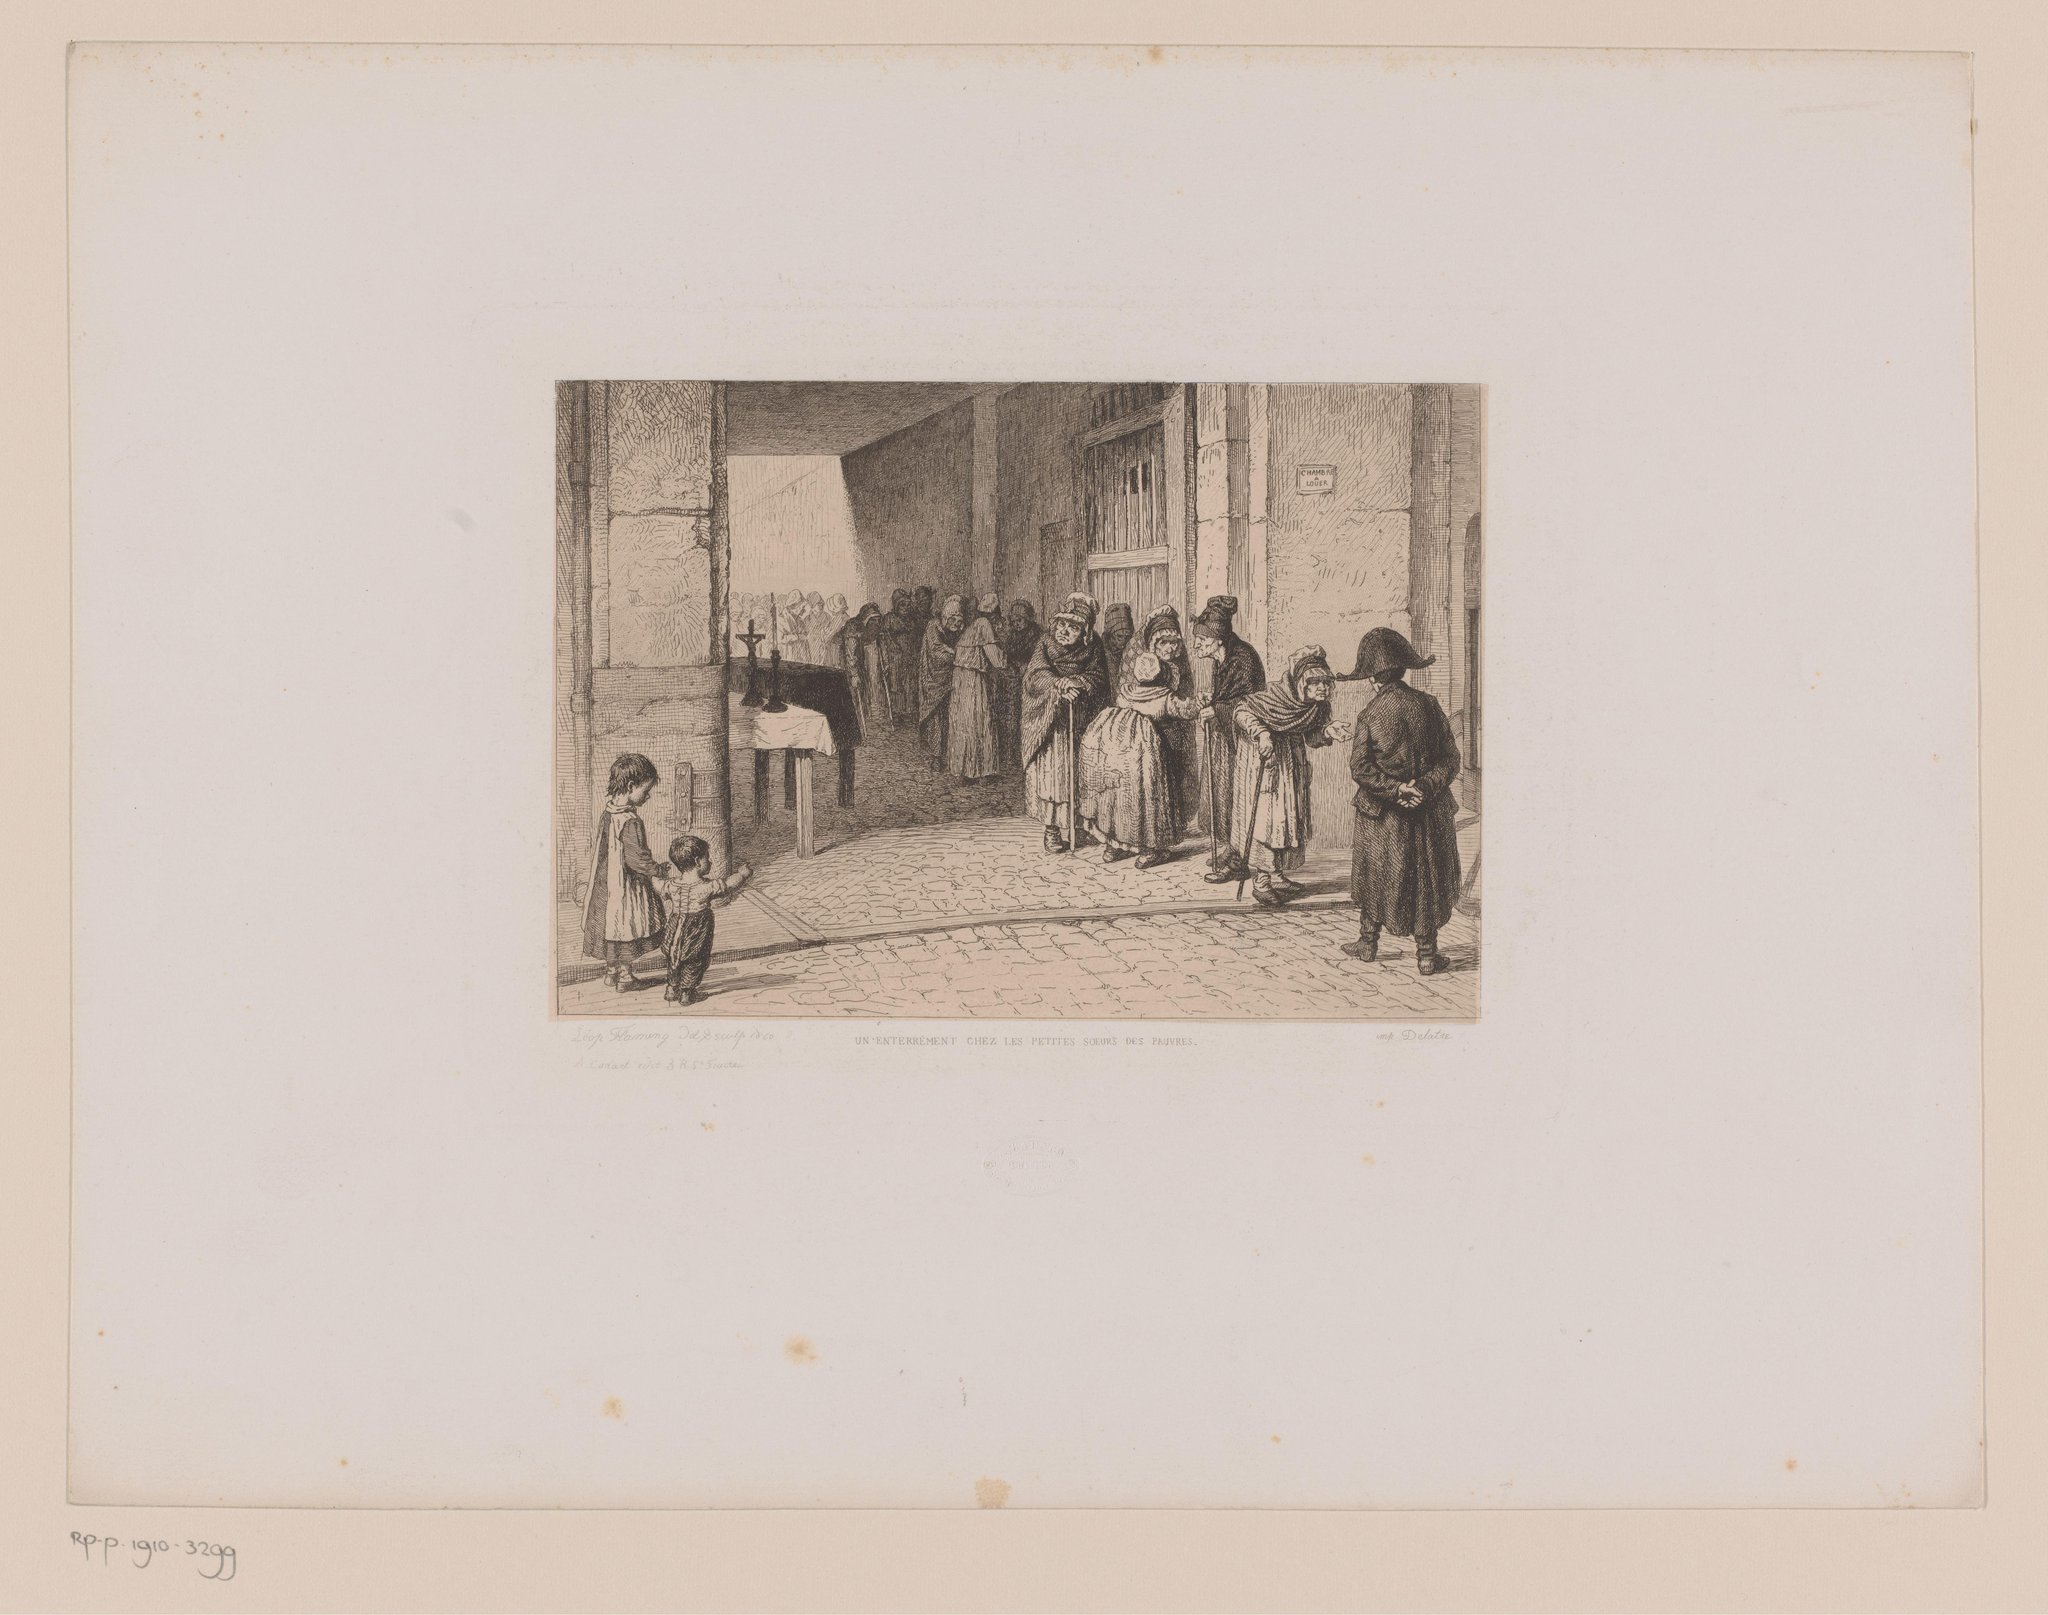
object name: print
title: Parijs komt en Parijs gaat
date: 1859-1860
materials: paper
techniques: etching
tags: cortege, funeral procession, paris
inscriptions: collector's mark: Lugt 2228, workshop stamp: ‘A. Cadart editeur 3 rue St. Fiacre Paris’